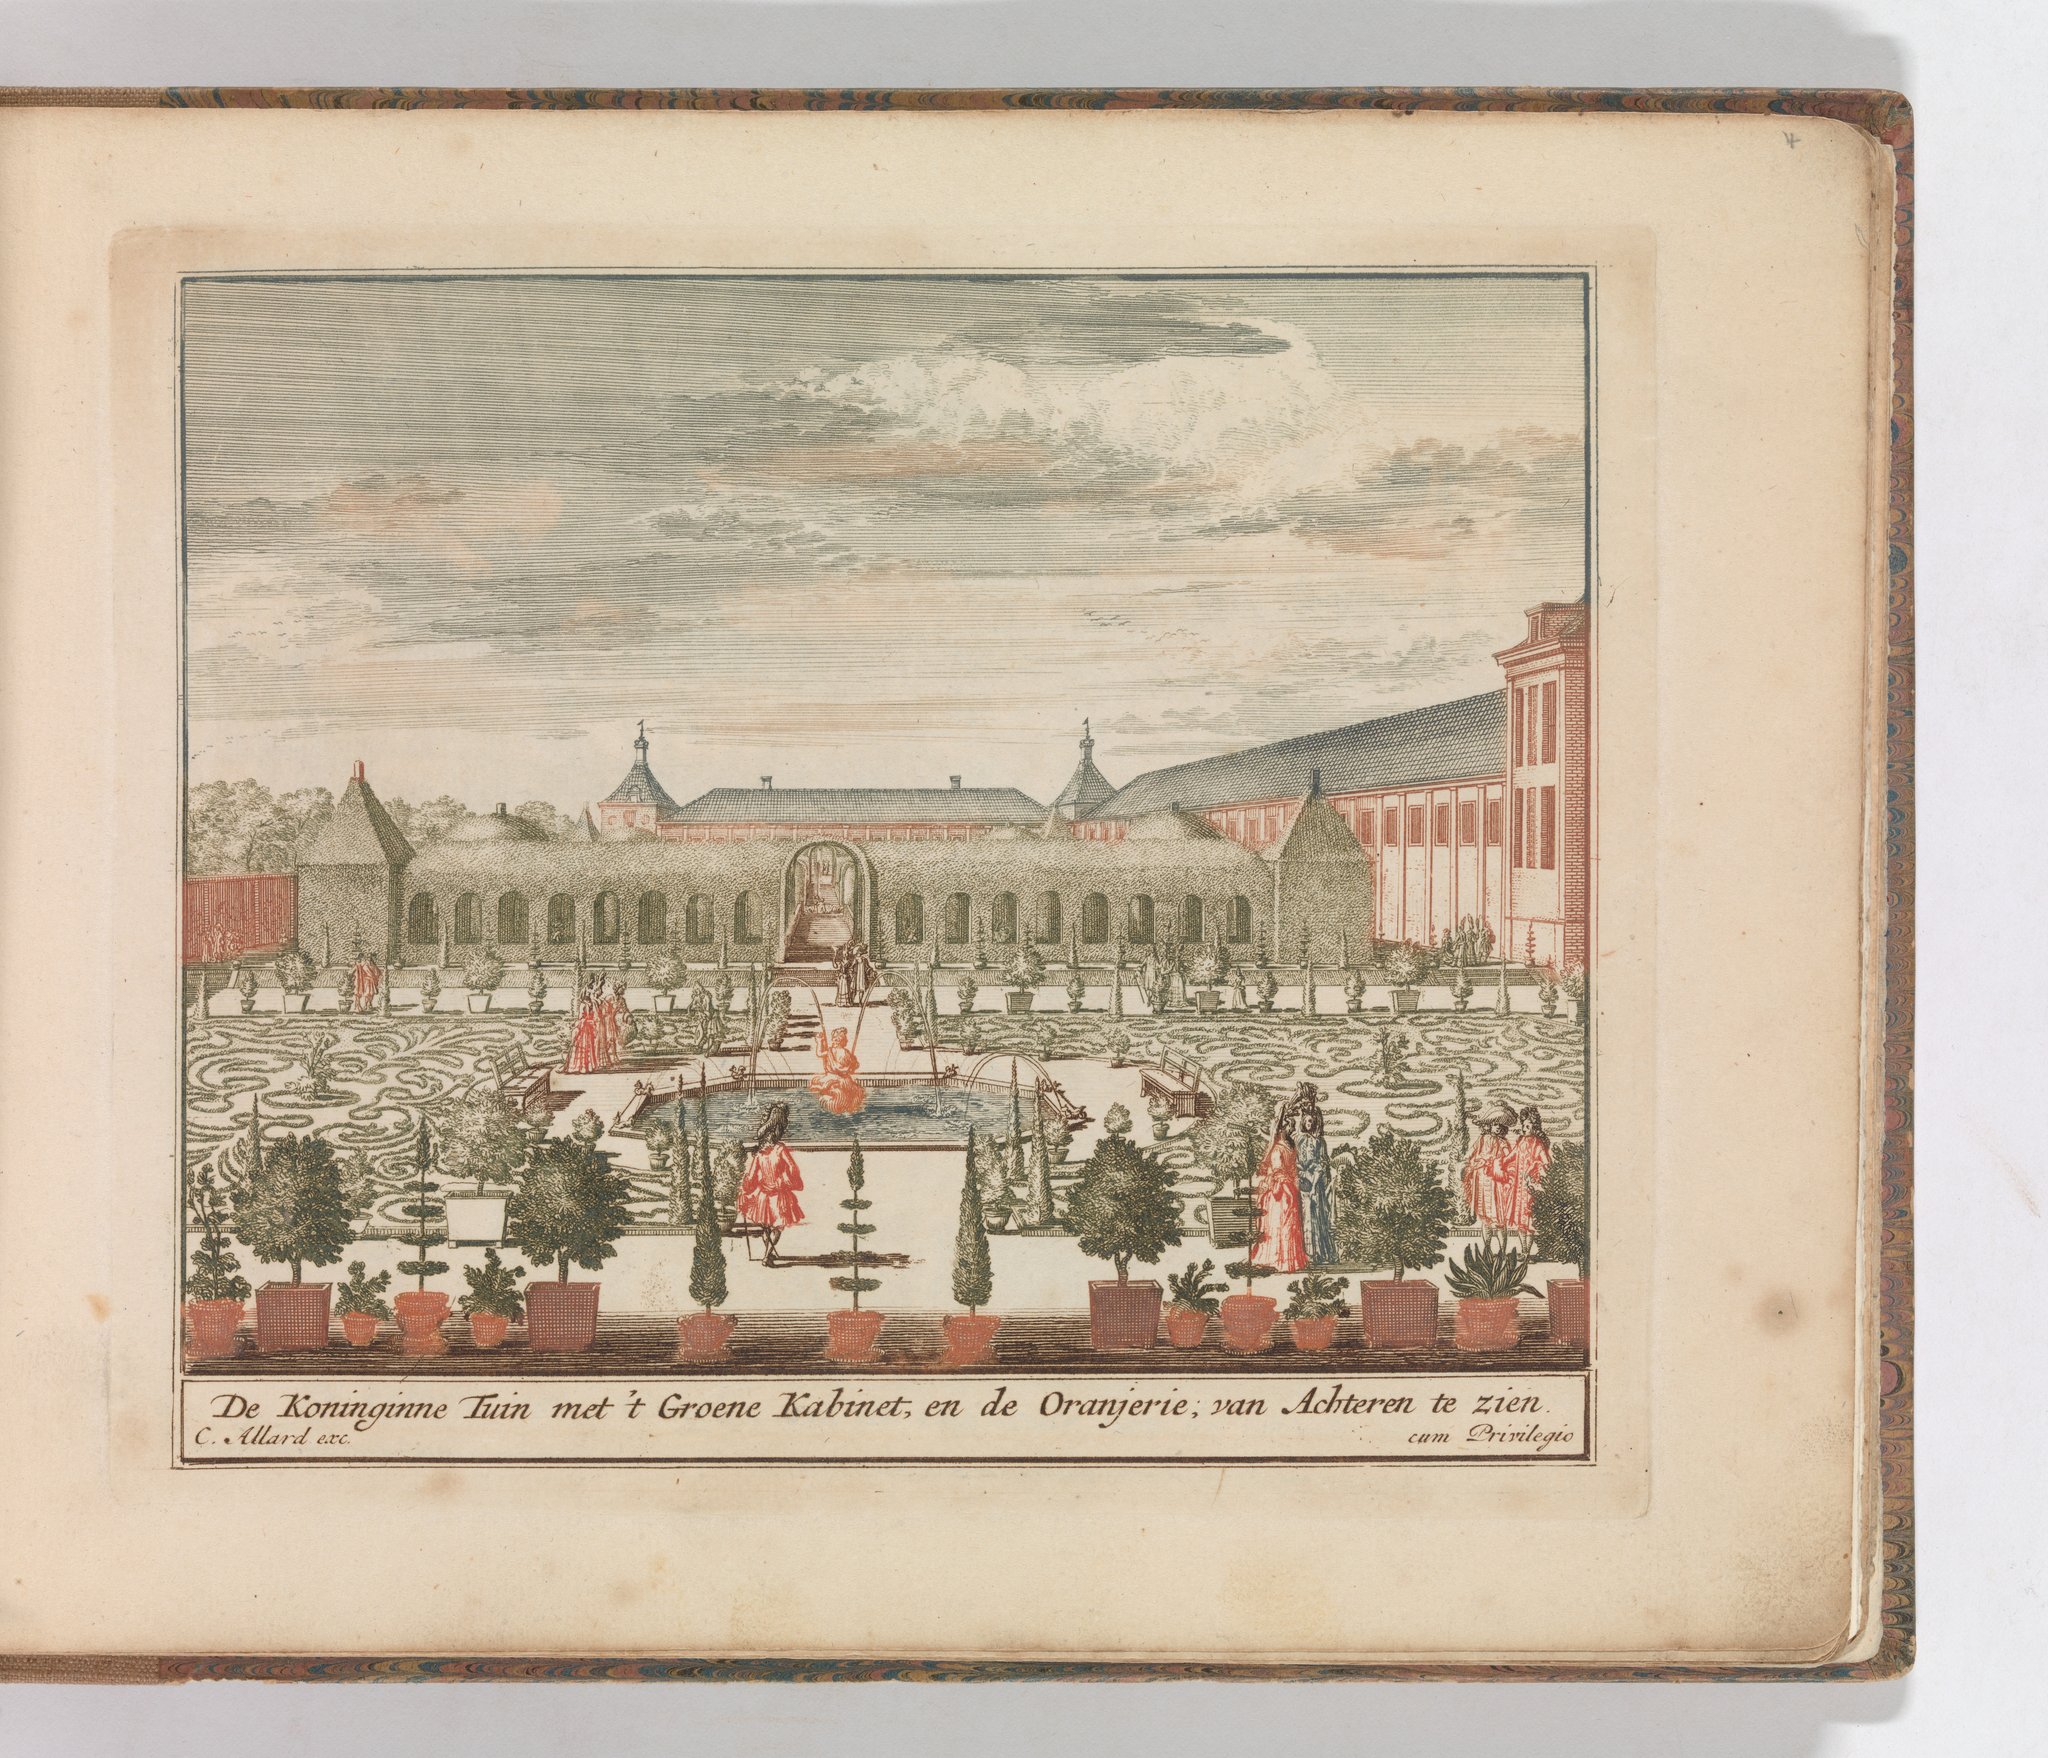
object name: book print ornament architecture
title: ' ’De Koninginne Tuin met 't Groene Kabinet , en de Oranjerie, van Achteren gezien", in: Tooneel Der Voornaamste Nederlands Huizen, En Lust Hoven, Naar T Leven Afgebeeld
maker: carel allard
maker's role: publisher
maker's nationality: dutch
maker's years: 1648-1709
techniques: engraving, lithography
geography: amsterdam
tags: palaces,gardens